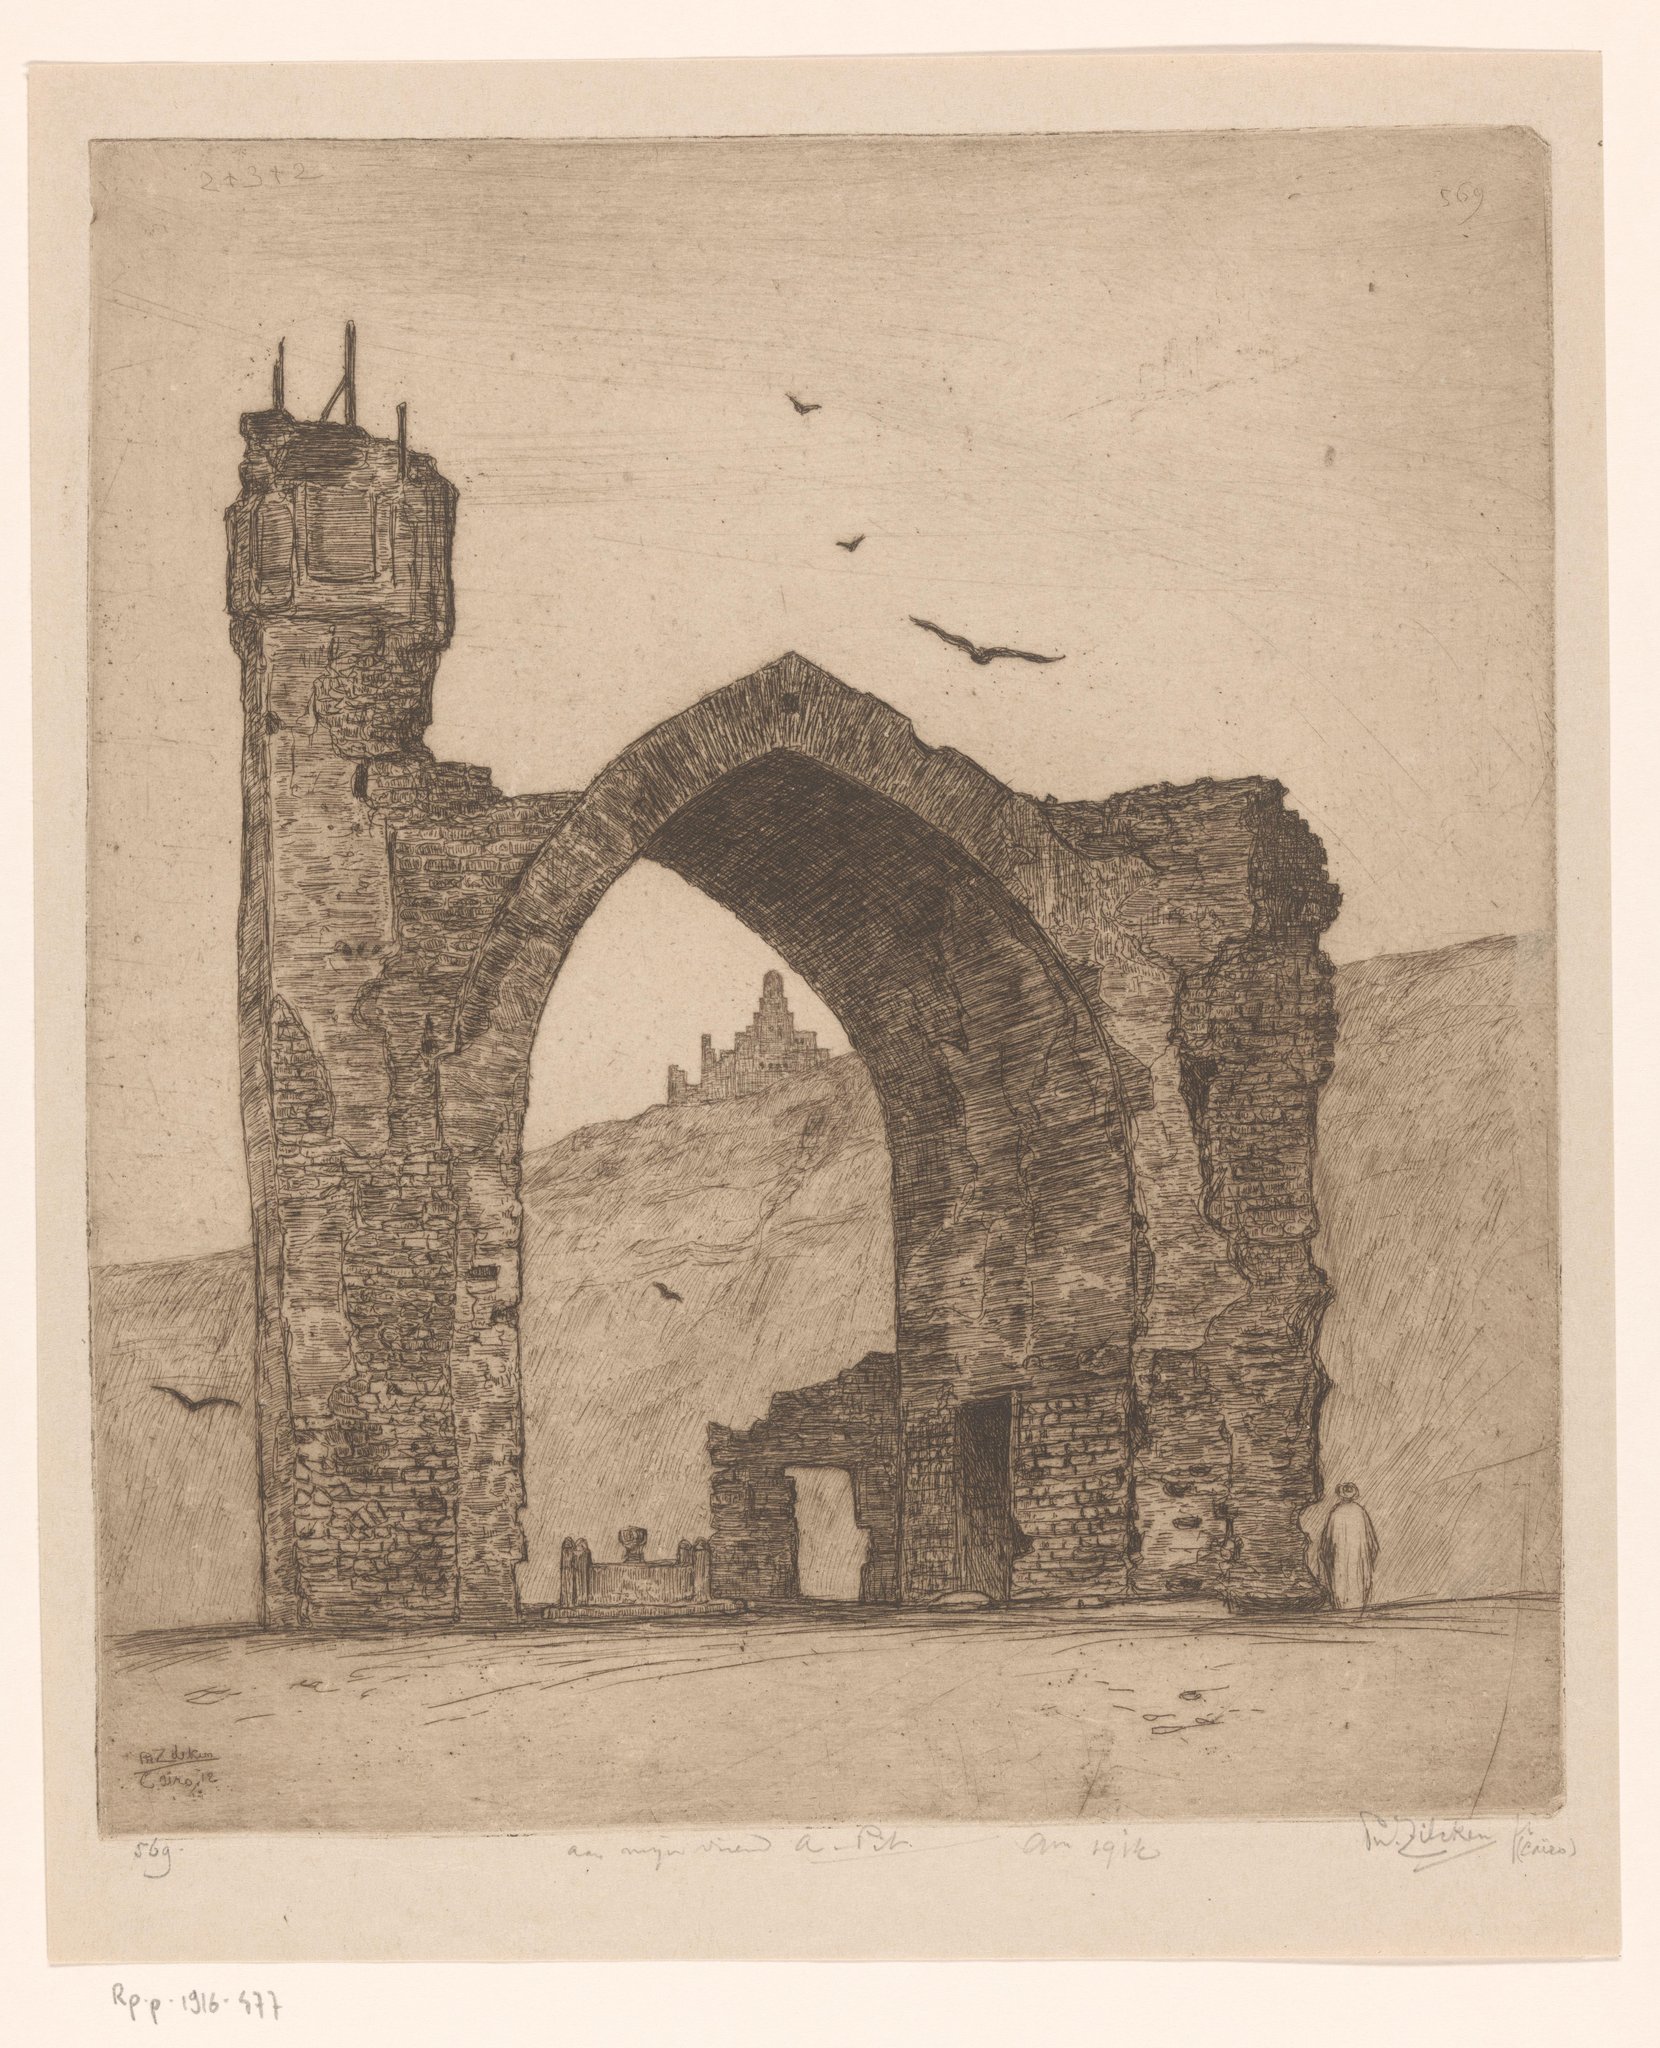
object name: print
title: Ruïnes in een woestijn, bij Caïro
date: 1912-1914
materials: paper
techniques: drypoint, etching, intaglio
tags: landscape with ruins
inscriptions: collector's mark: Lugt 2233